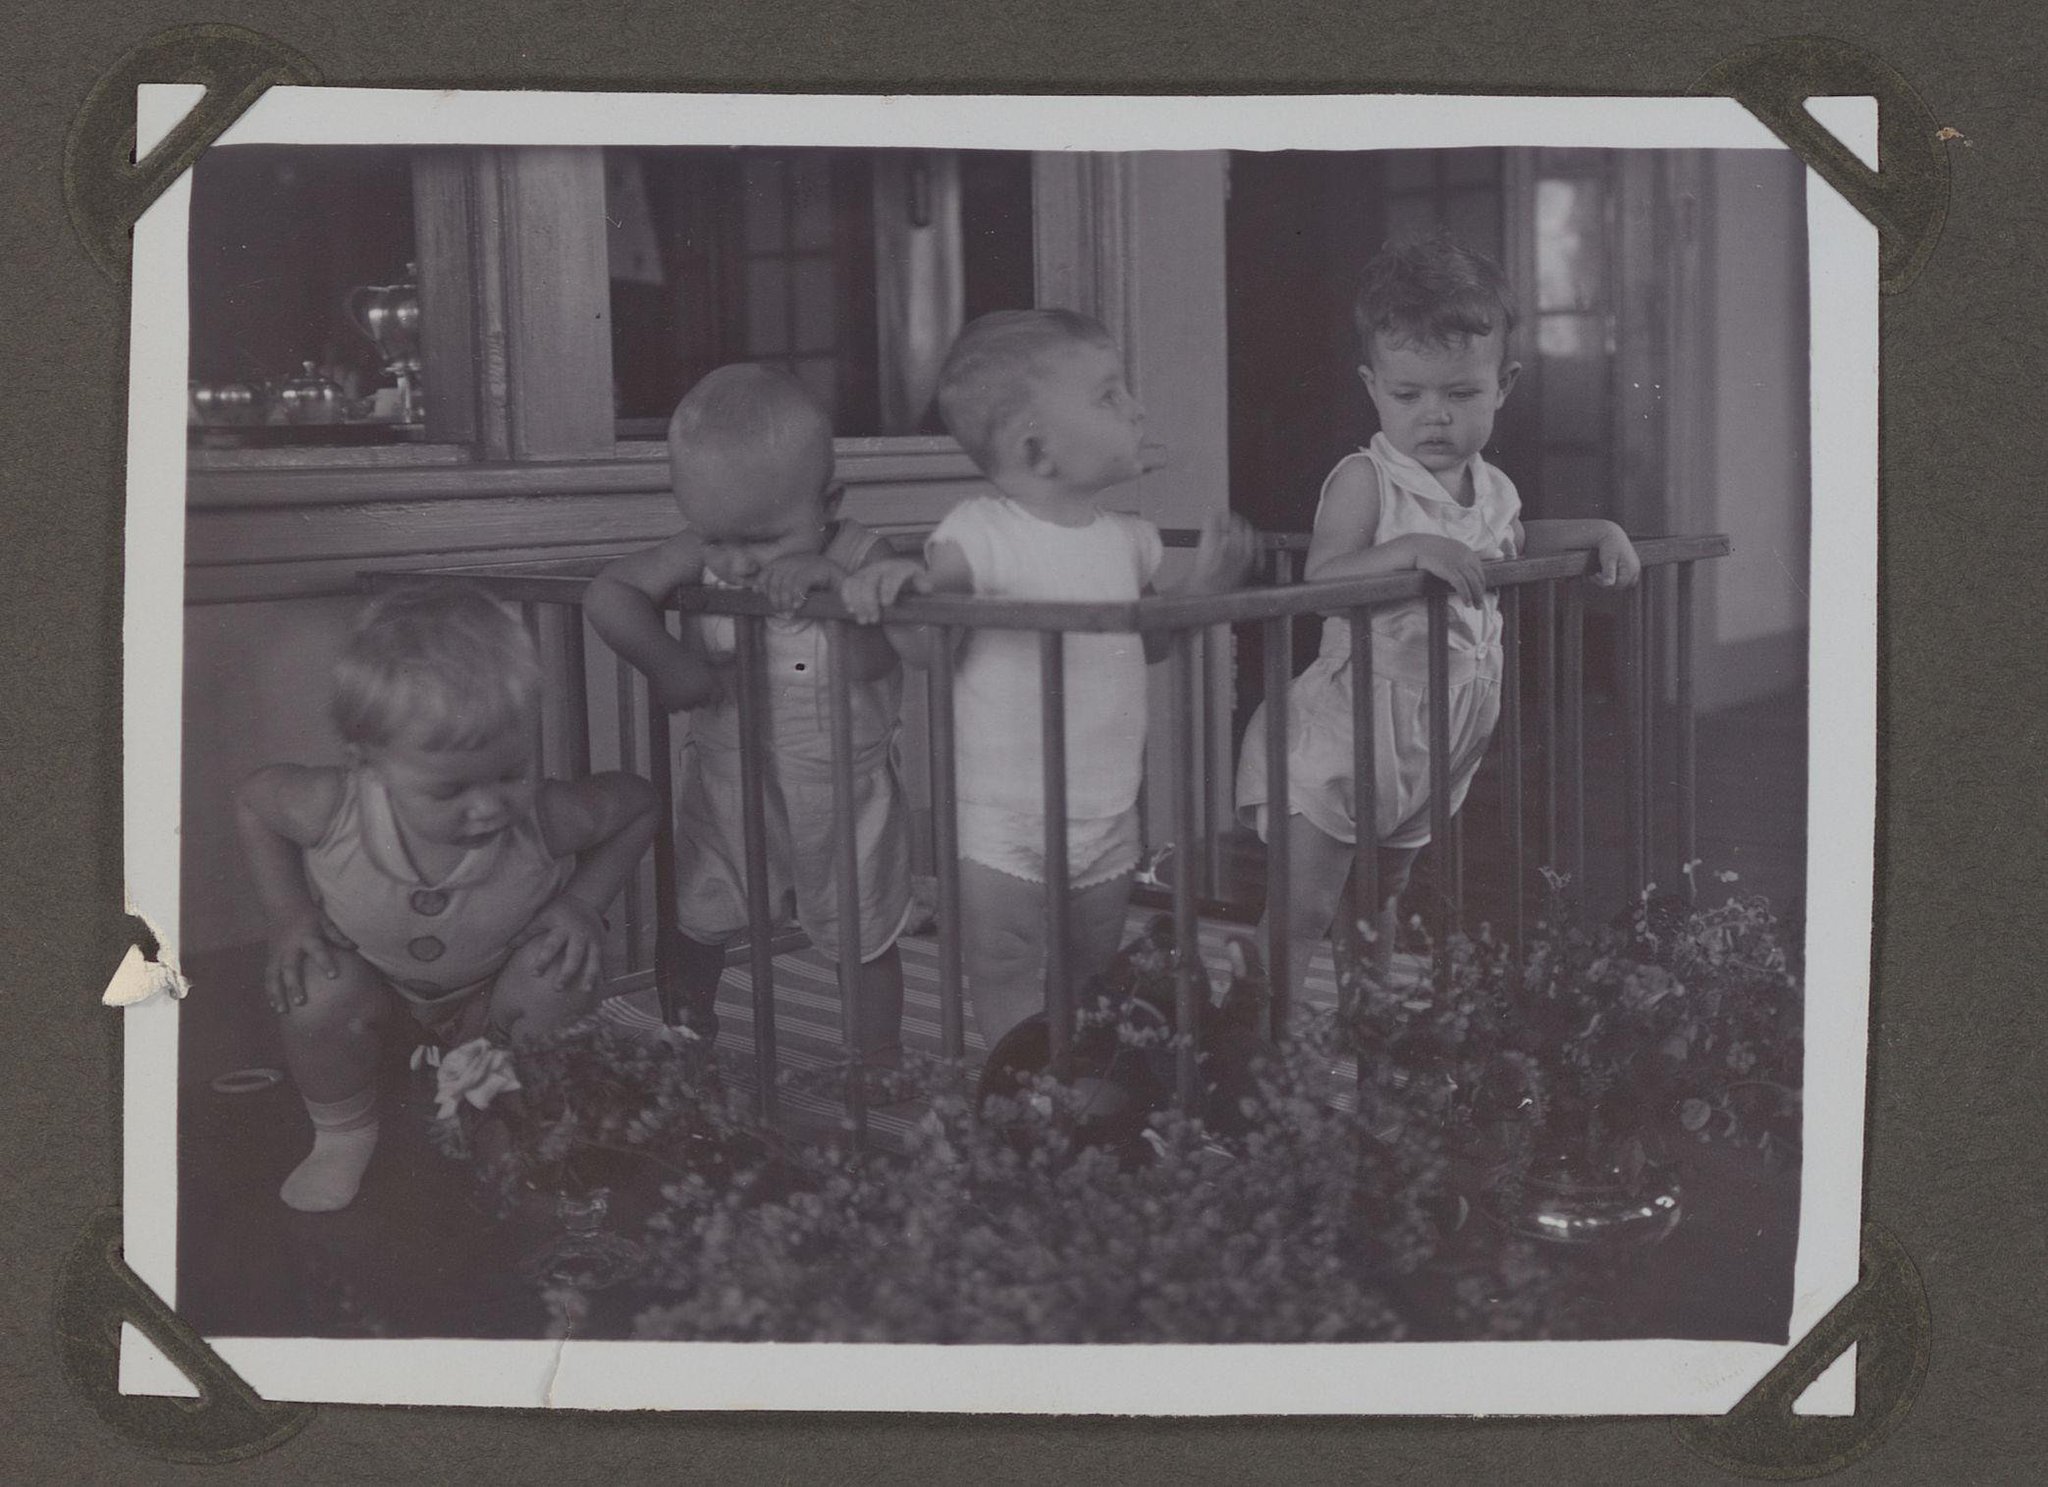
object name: photograph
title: Familiefoto van de kinderen Jetten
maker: Anonymous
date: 1925-1927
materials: photographic support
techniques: photography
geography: suriname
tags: jetten, familie, moengo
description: Familiefoto van de kinderen Jetten. Foto op een bladzijde van een los albumblad. Onderdeel van het ensemble met foto's van de familie van ingenieur Jetten in de mijnbouwstad Moengo in Suriname.